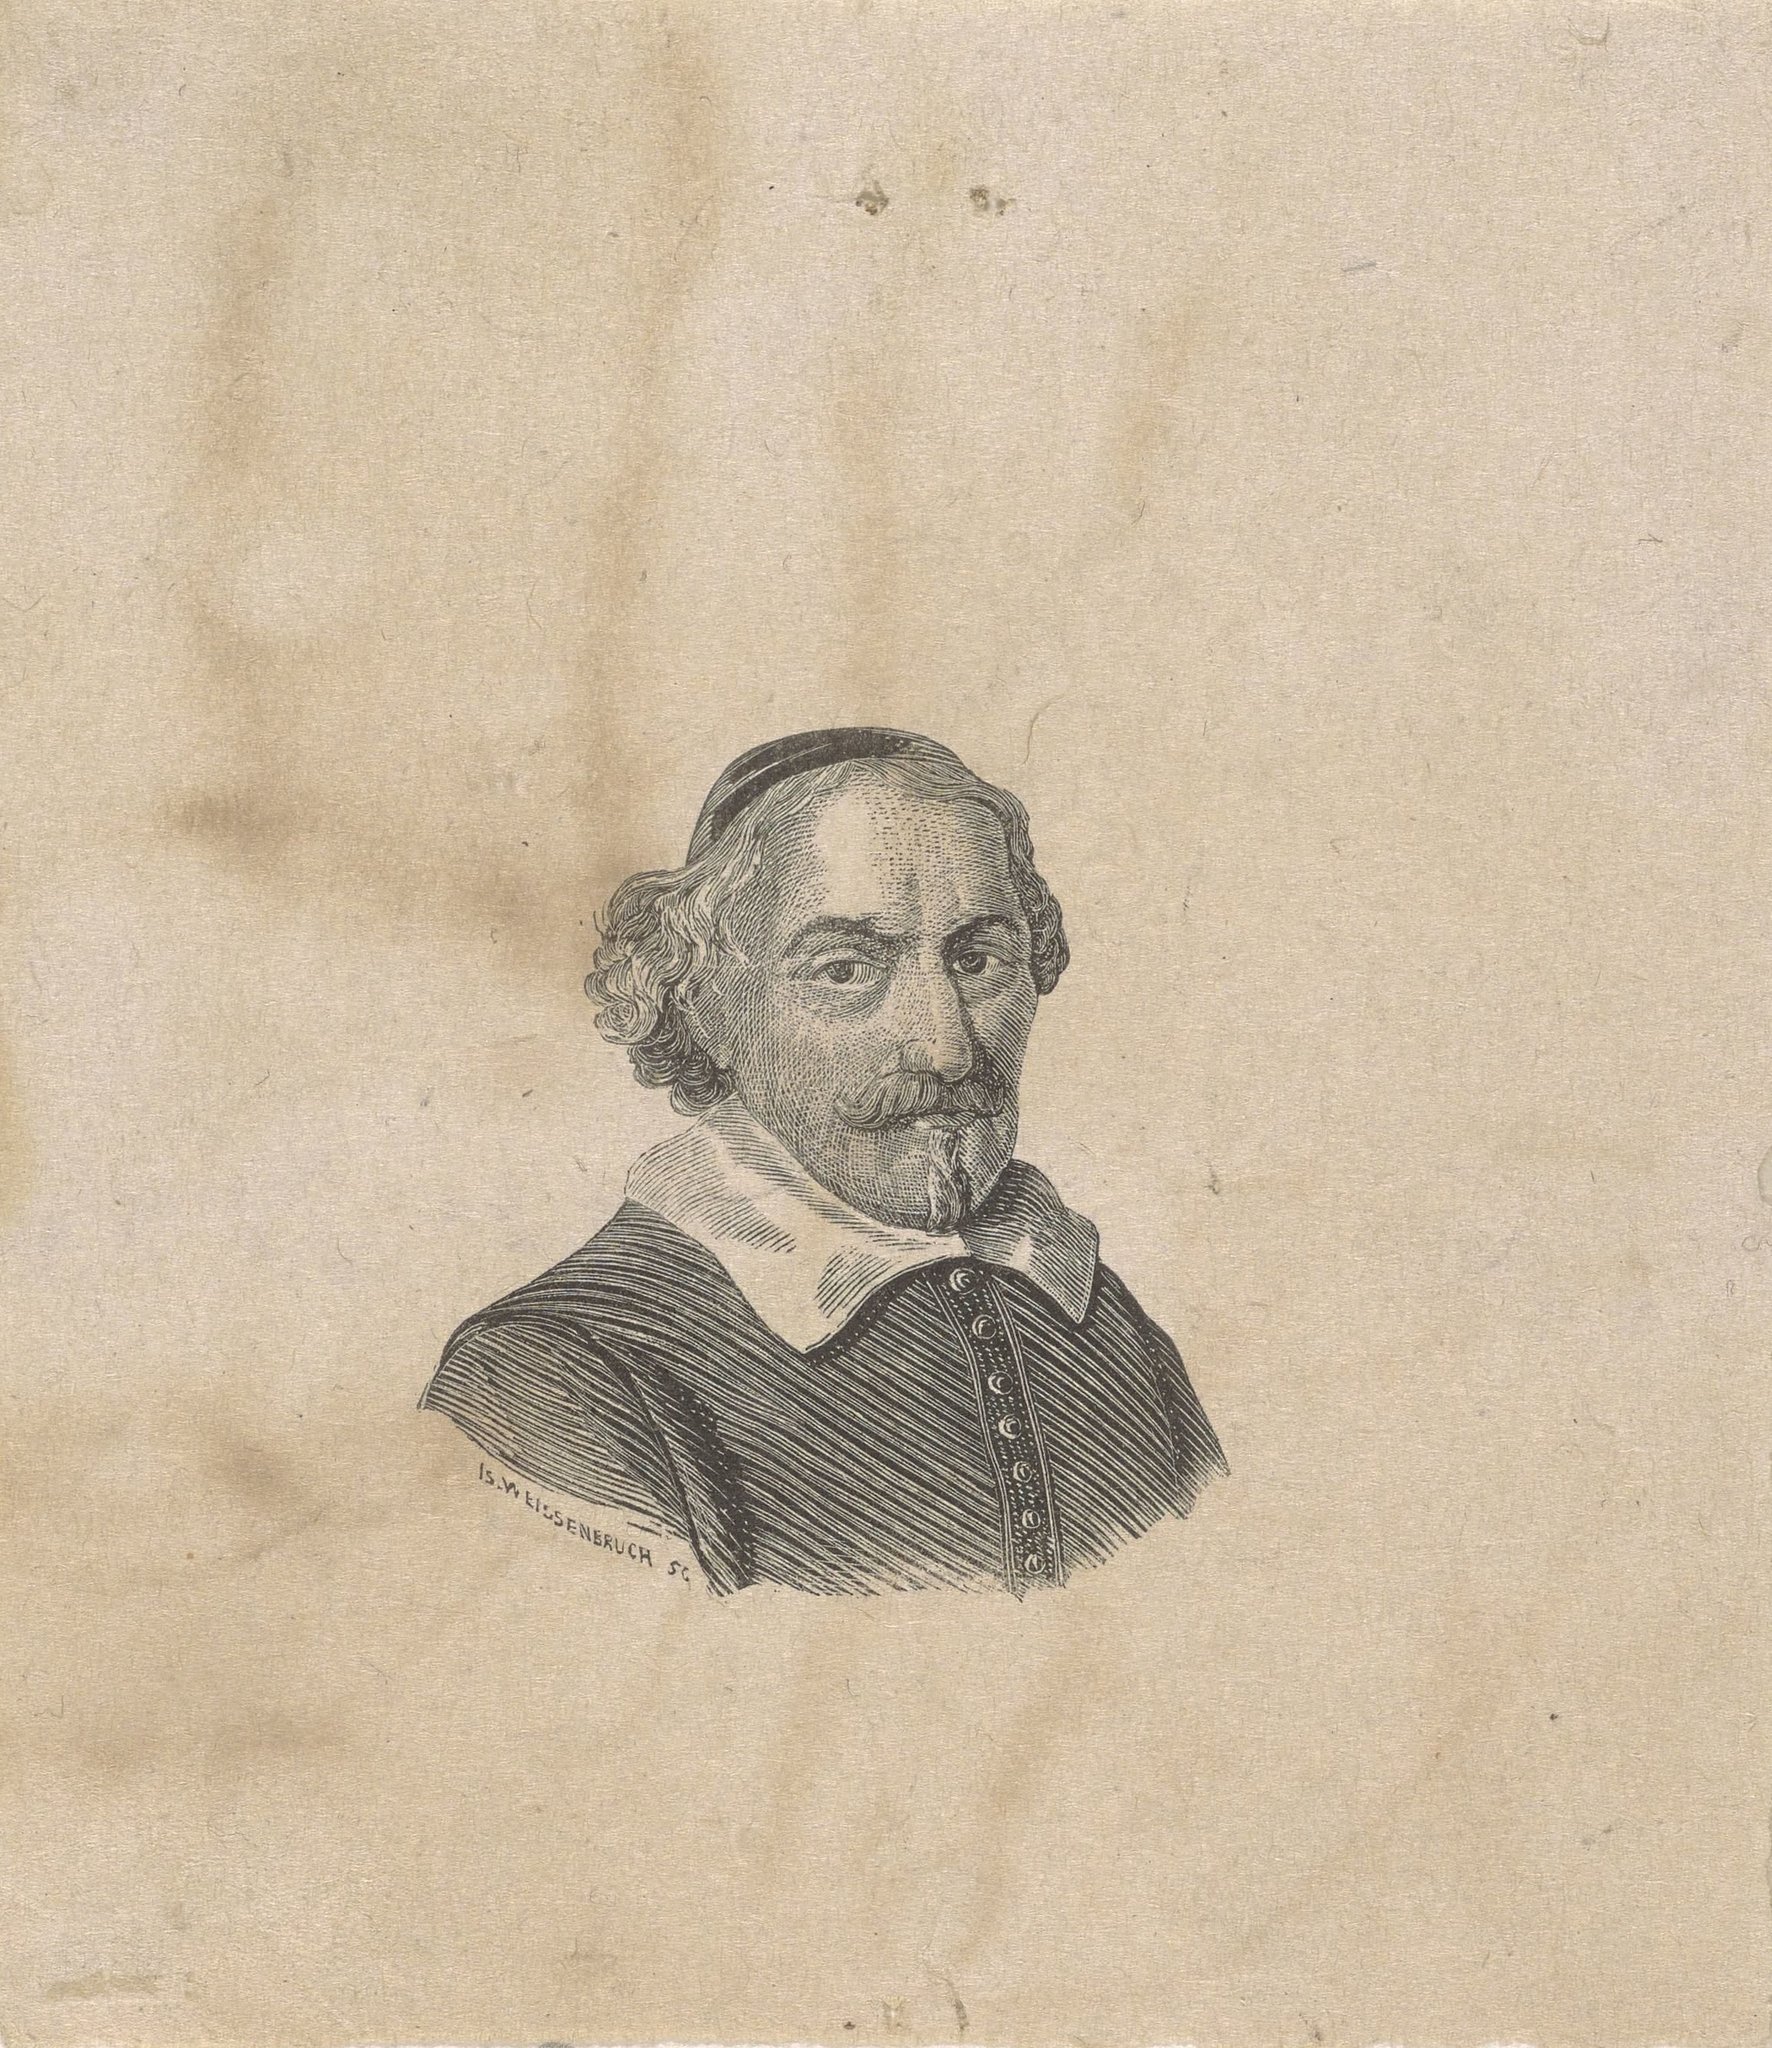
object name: print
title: Portret van Joost van den Vondel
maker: isaac weissenbruch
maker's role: print maker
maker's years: 1826-1912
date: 1836-1912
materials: paper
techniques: engraving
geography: netherlands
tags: cologne, amsterdam, joost van den vondel